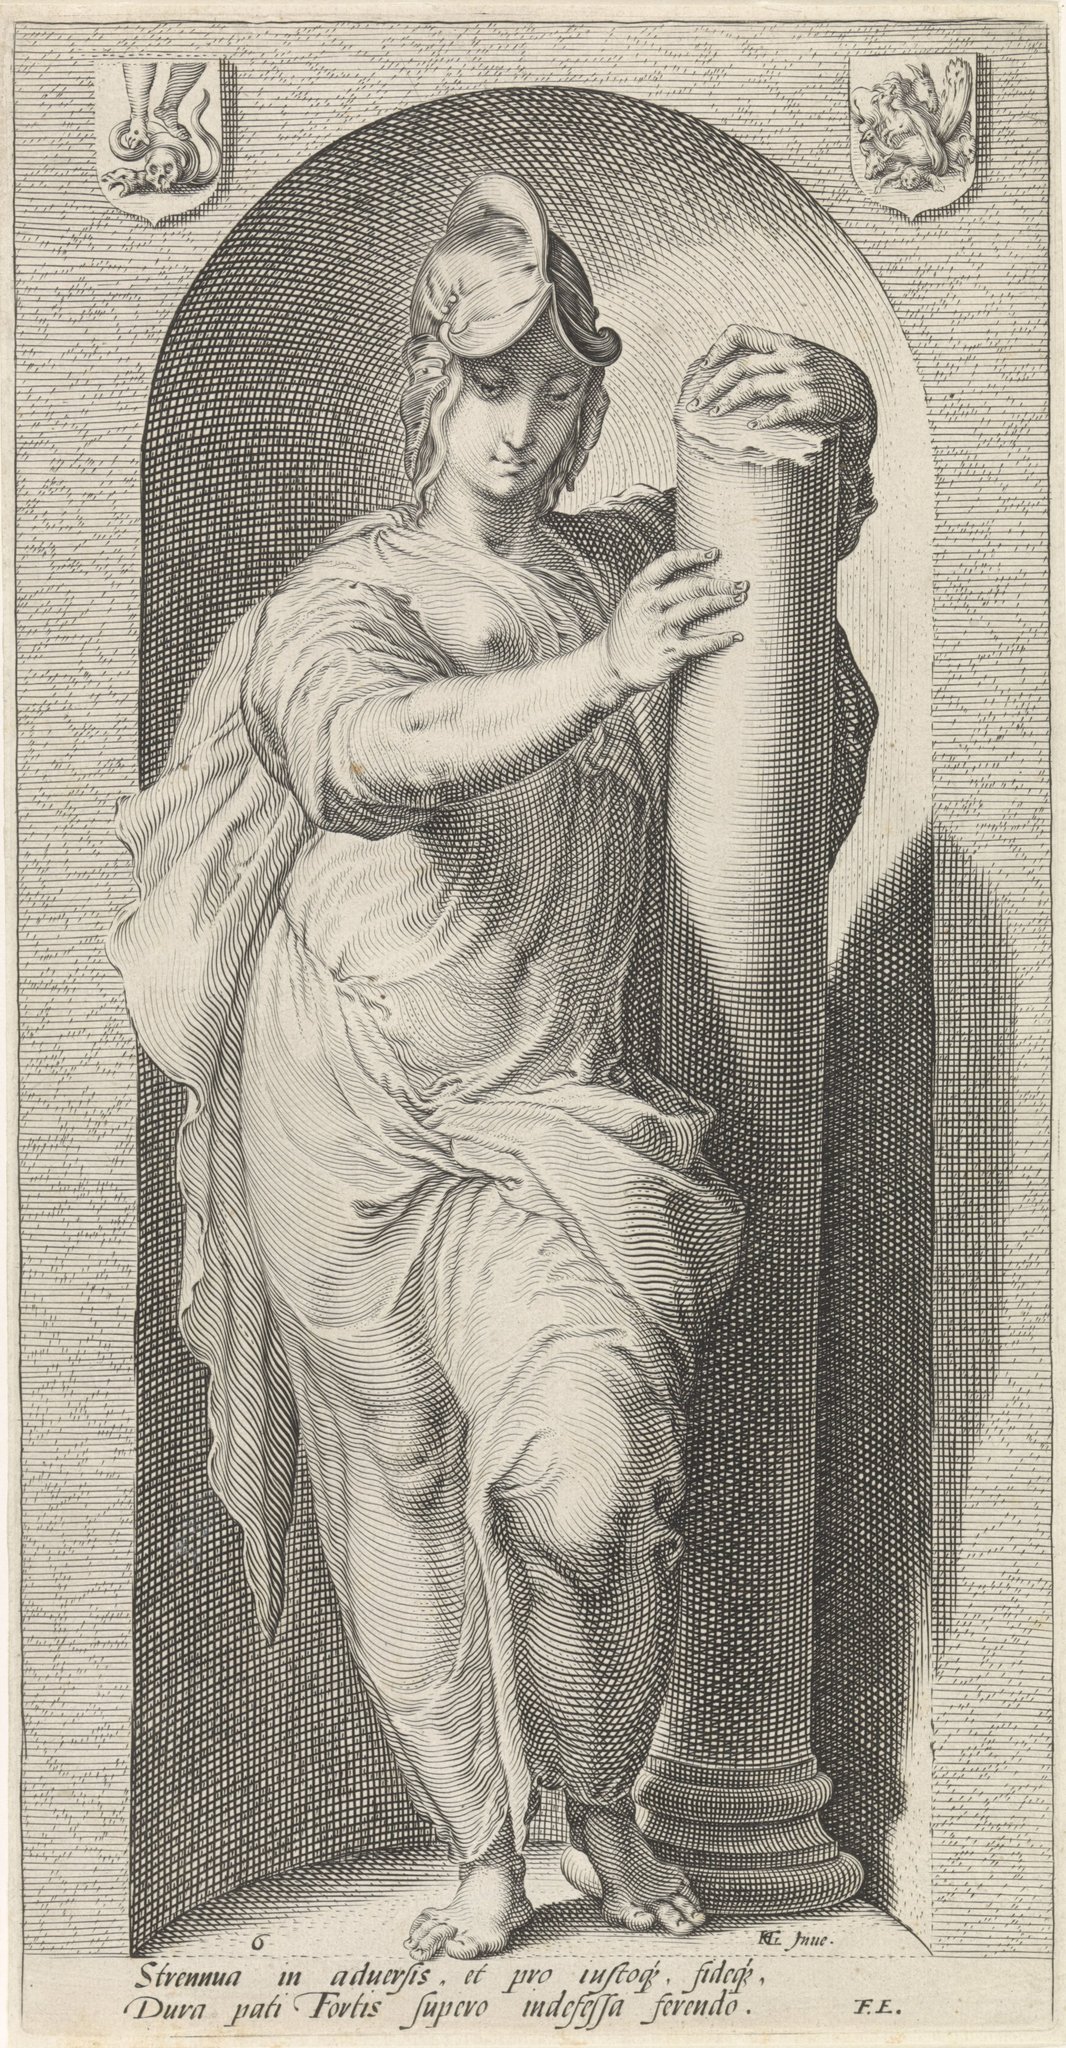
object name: print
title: Kracht (Fortitudo)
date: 1593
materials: paper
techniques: engraving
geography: northern netherlands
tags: fortitude, 'fortitudo' ~ one of the four cardinal virtues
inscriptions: collector's mark: Lugt 2228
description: Staande vrouw naast een zuil, in een nis, als personificatie van kracht.